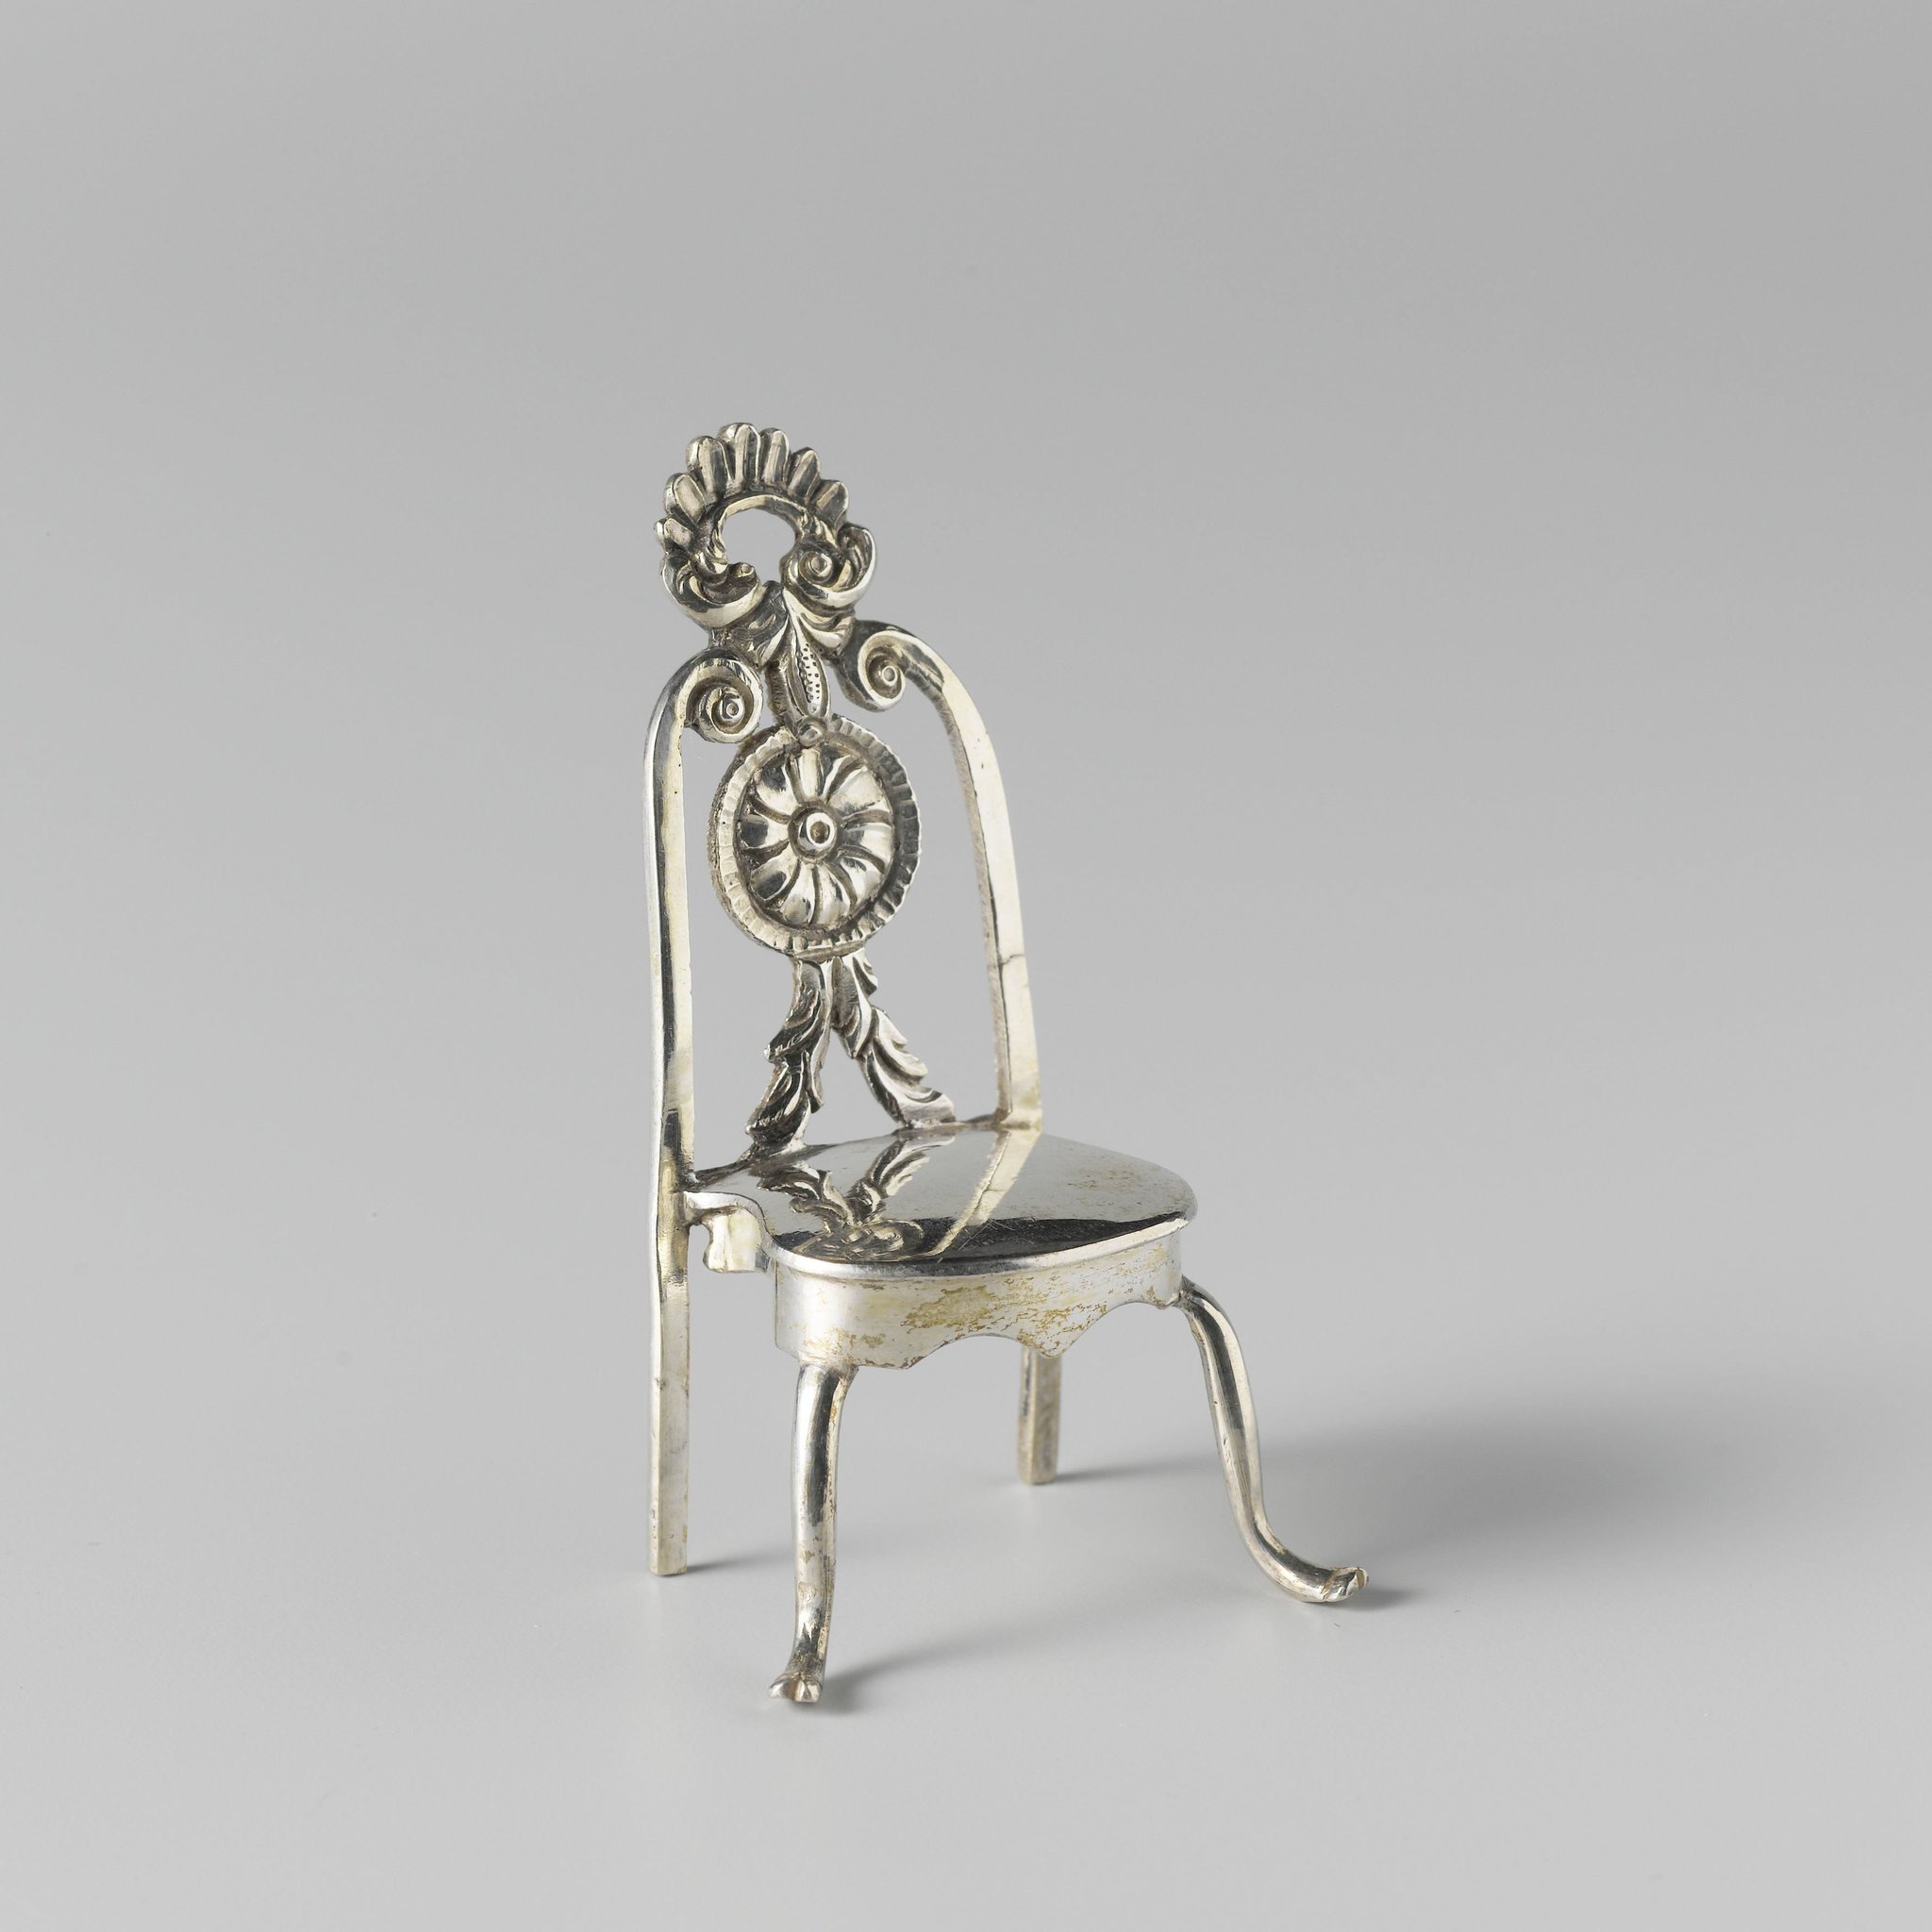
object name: miniature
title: Stoel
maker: jan bonket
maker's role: silversmith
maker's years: 1727-1789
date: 1779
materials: silver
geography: amsterdam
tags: chair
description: Stoel met gladde, kolfvormige zitting en voluutvormige voorpoten. De opengewerkte rugleuning wordt bekroond door een kuif. Het midden van de rugleuning wordt gevormd door een rozet en bladslingers. De stoel is gemerkt: stk.= Amsterdam, jrl.= 1779, mt.= Jan Bonket. De stoel hoort bij vijf identieke exemplaren (BK-NM-11177-169, BK-NM-11177-170, BK-NM-11177-171, BK-NM-11177-172 en BK-NM-11177-174).